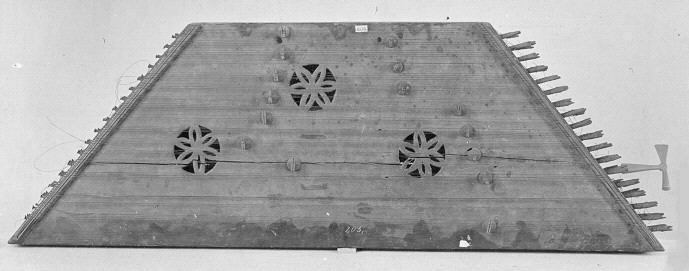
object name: santir santur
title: Santir (santur)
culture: turkish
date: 1867-1900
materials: wood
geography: turkey